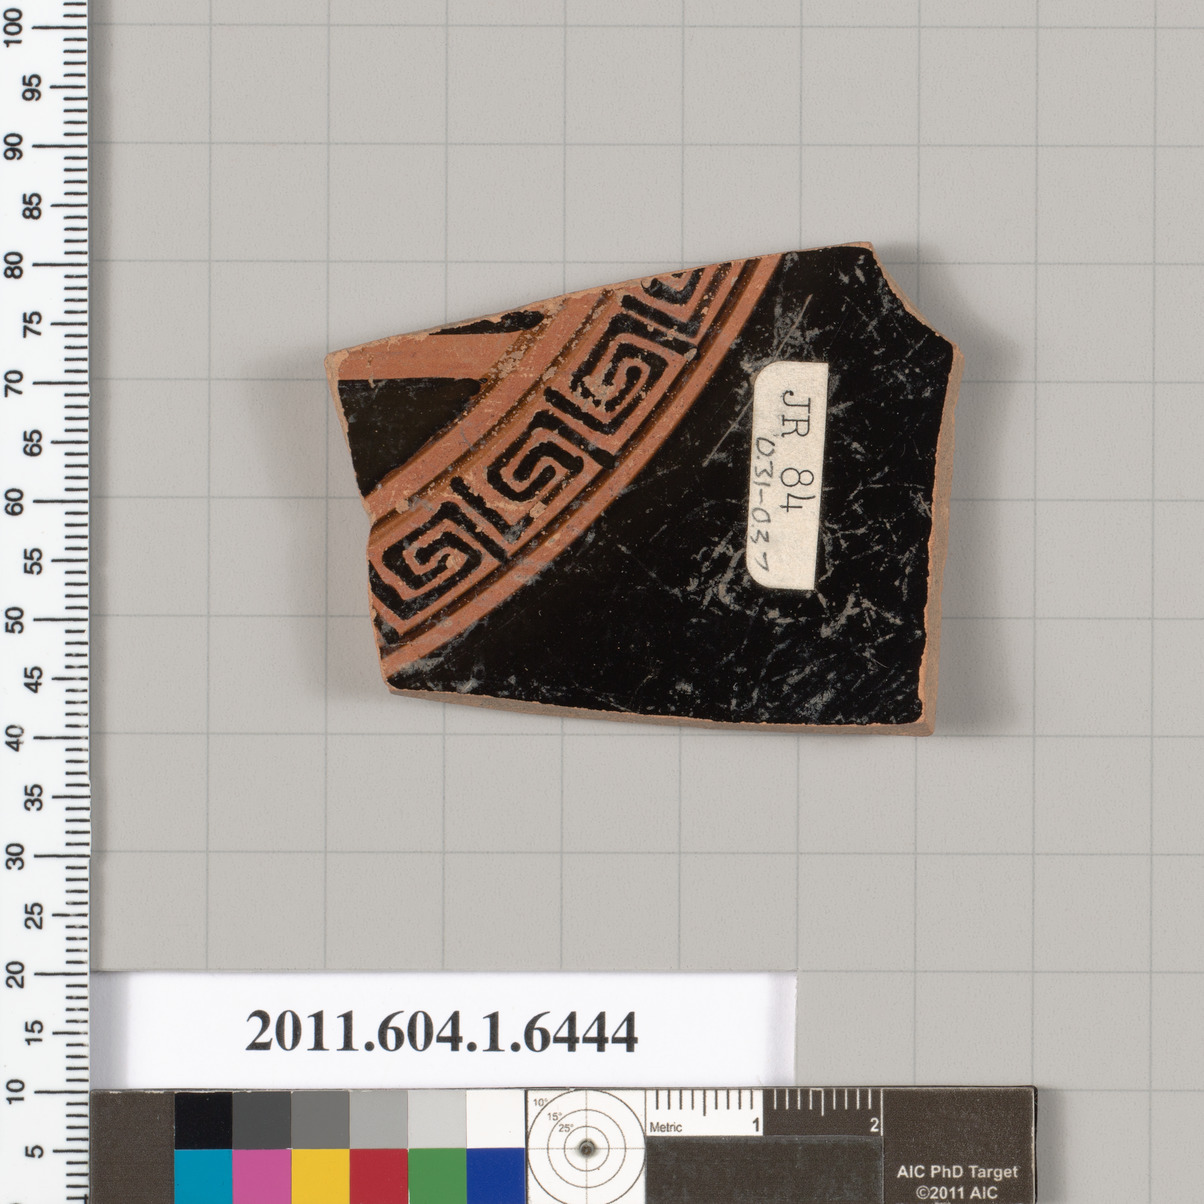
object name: kylix fragment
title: Terracotta fragment of a kylix (drinking cup)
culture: greek, attic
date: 490-480 BCE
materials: terracotta